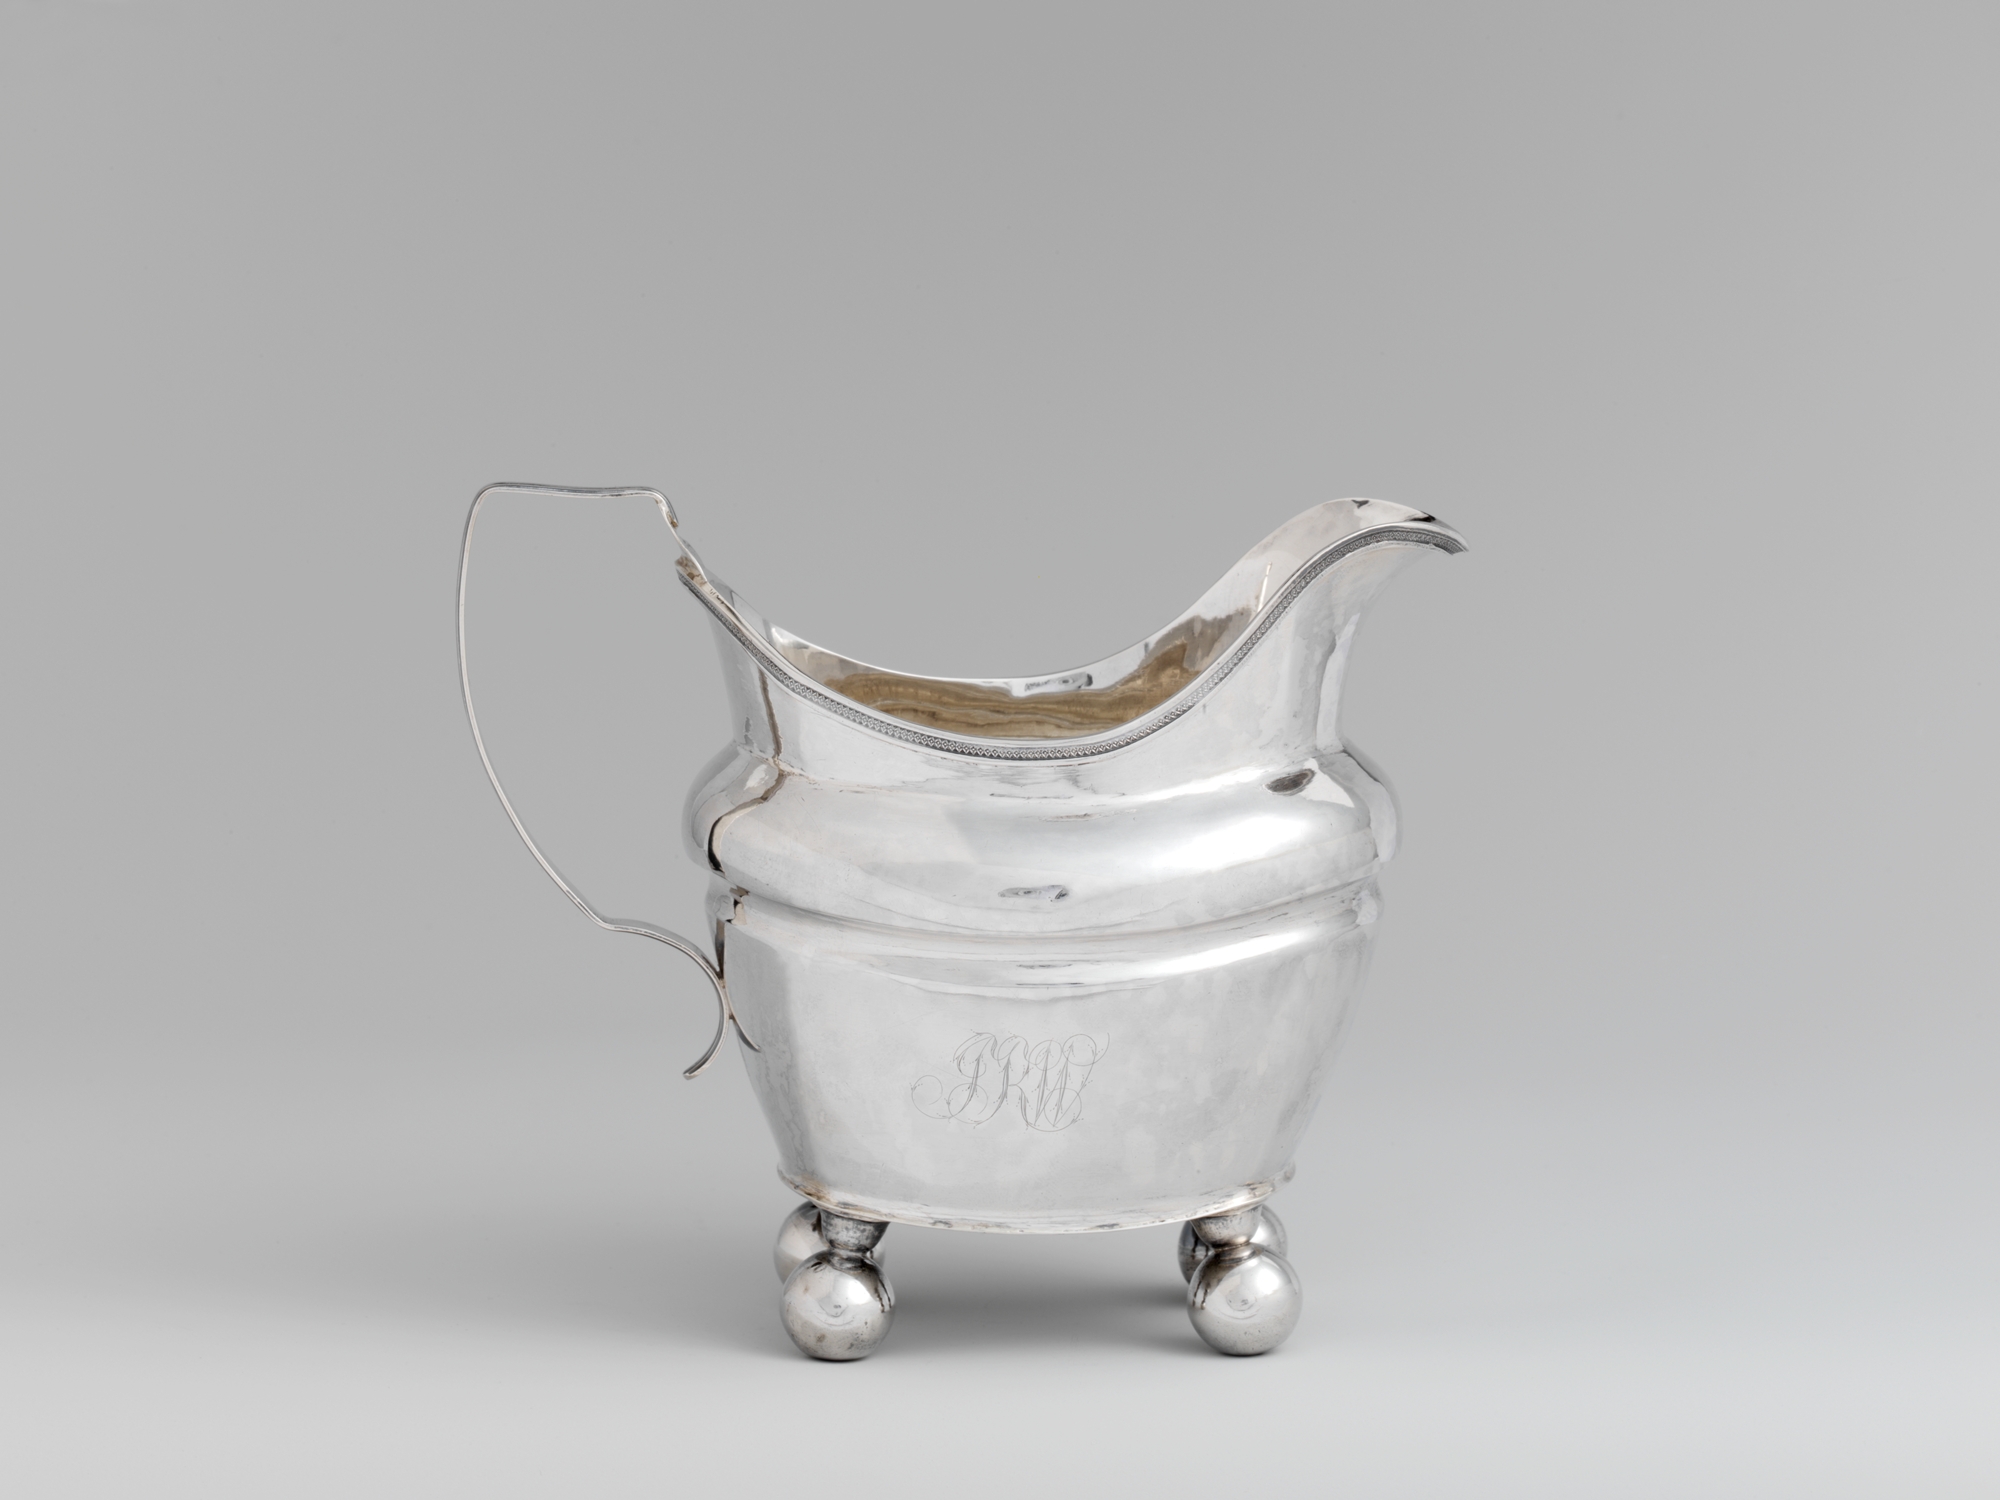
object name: cream pot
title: Creamer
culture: american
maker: isaac hutton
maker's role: maker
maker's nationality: american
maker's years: 1766-1855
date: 1810-1830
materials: silver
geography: united states